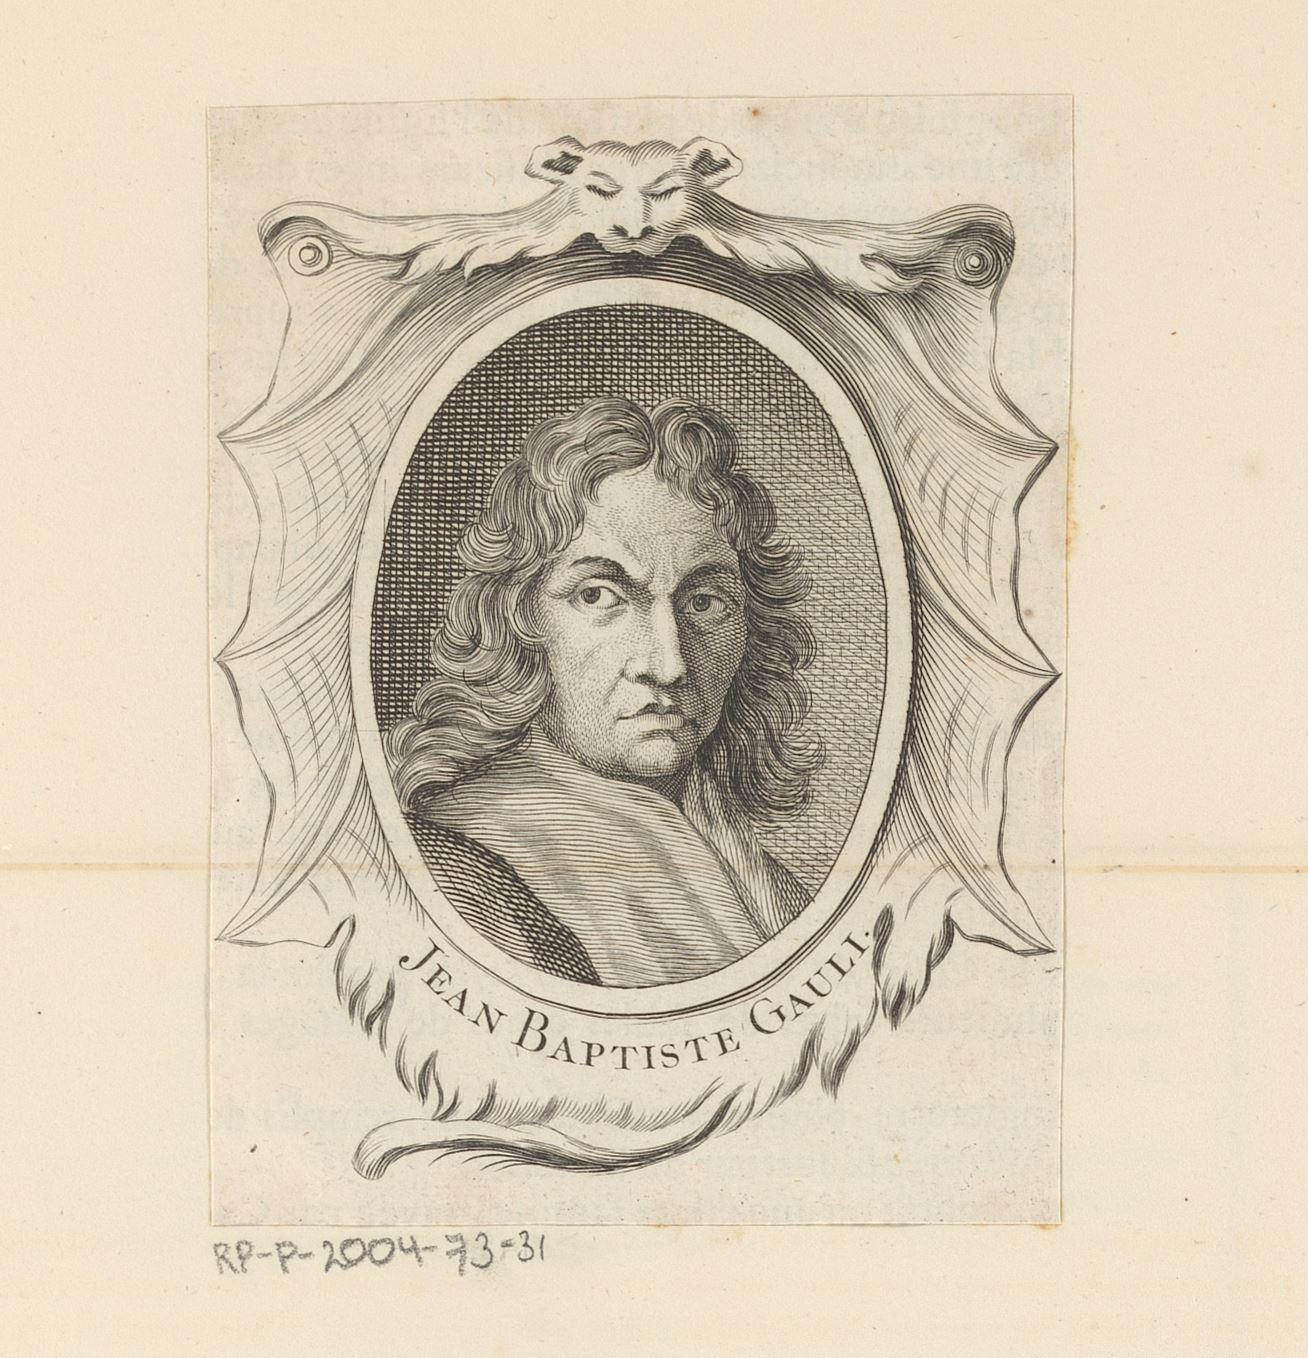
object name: print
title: Portret van Giovanni Battista Gaulli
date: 1745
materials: paper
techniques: engraving, letterpress printing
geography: paris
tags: draughtsman, giovanni battista gaulli, historical persons, portrait, self-portrait of painter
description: Prent uit: Dézallier d'Argenville, Antoine Joseph. Abrégé de la vie des plus fameux peintres. 4 dln. Parijs: De Bure l'aîné, 1745, dl. 1, p. 386. De samensteller heeft deze prent in het album geplakt als illustratie bij: Pilkington, Matthew en Johann Heinrich Füssli. A dictionary of painters, from the revival of the art to the present period. 4 dln. Londen: John Crowder, 1805, dl. 2, p. 211.